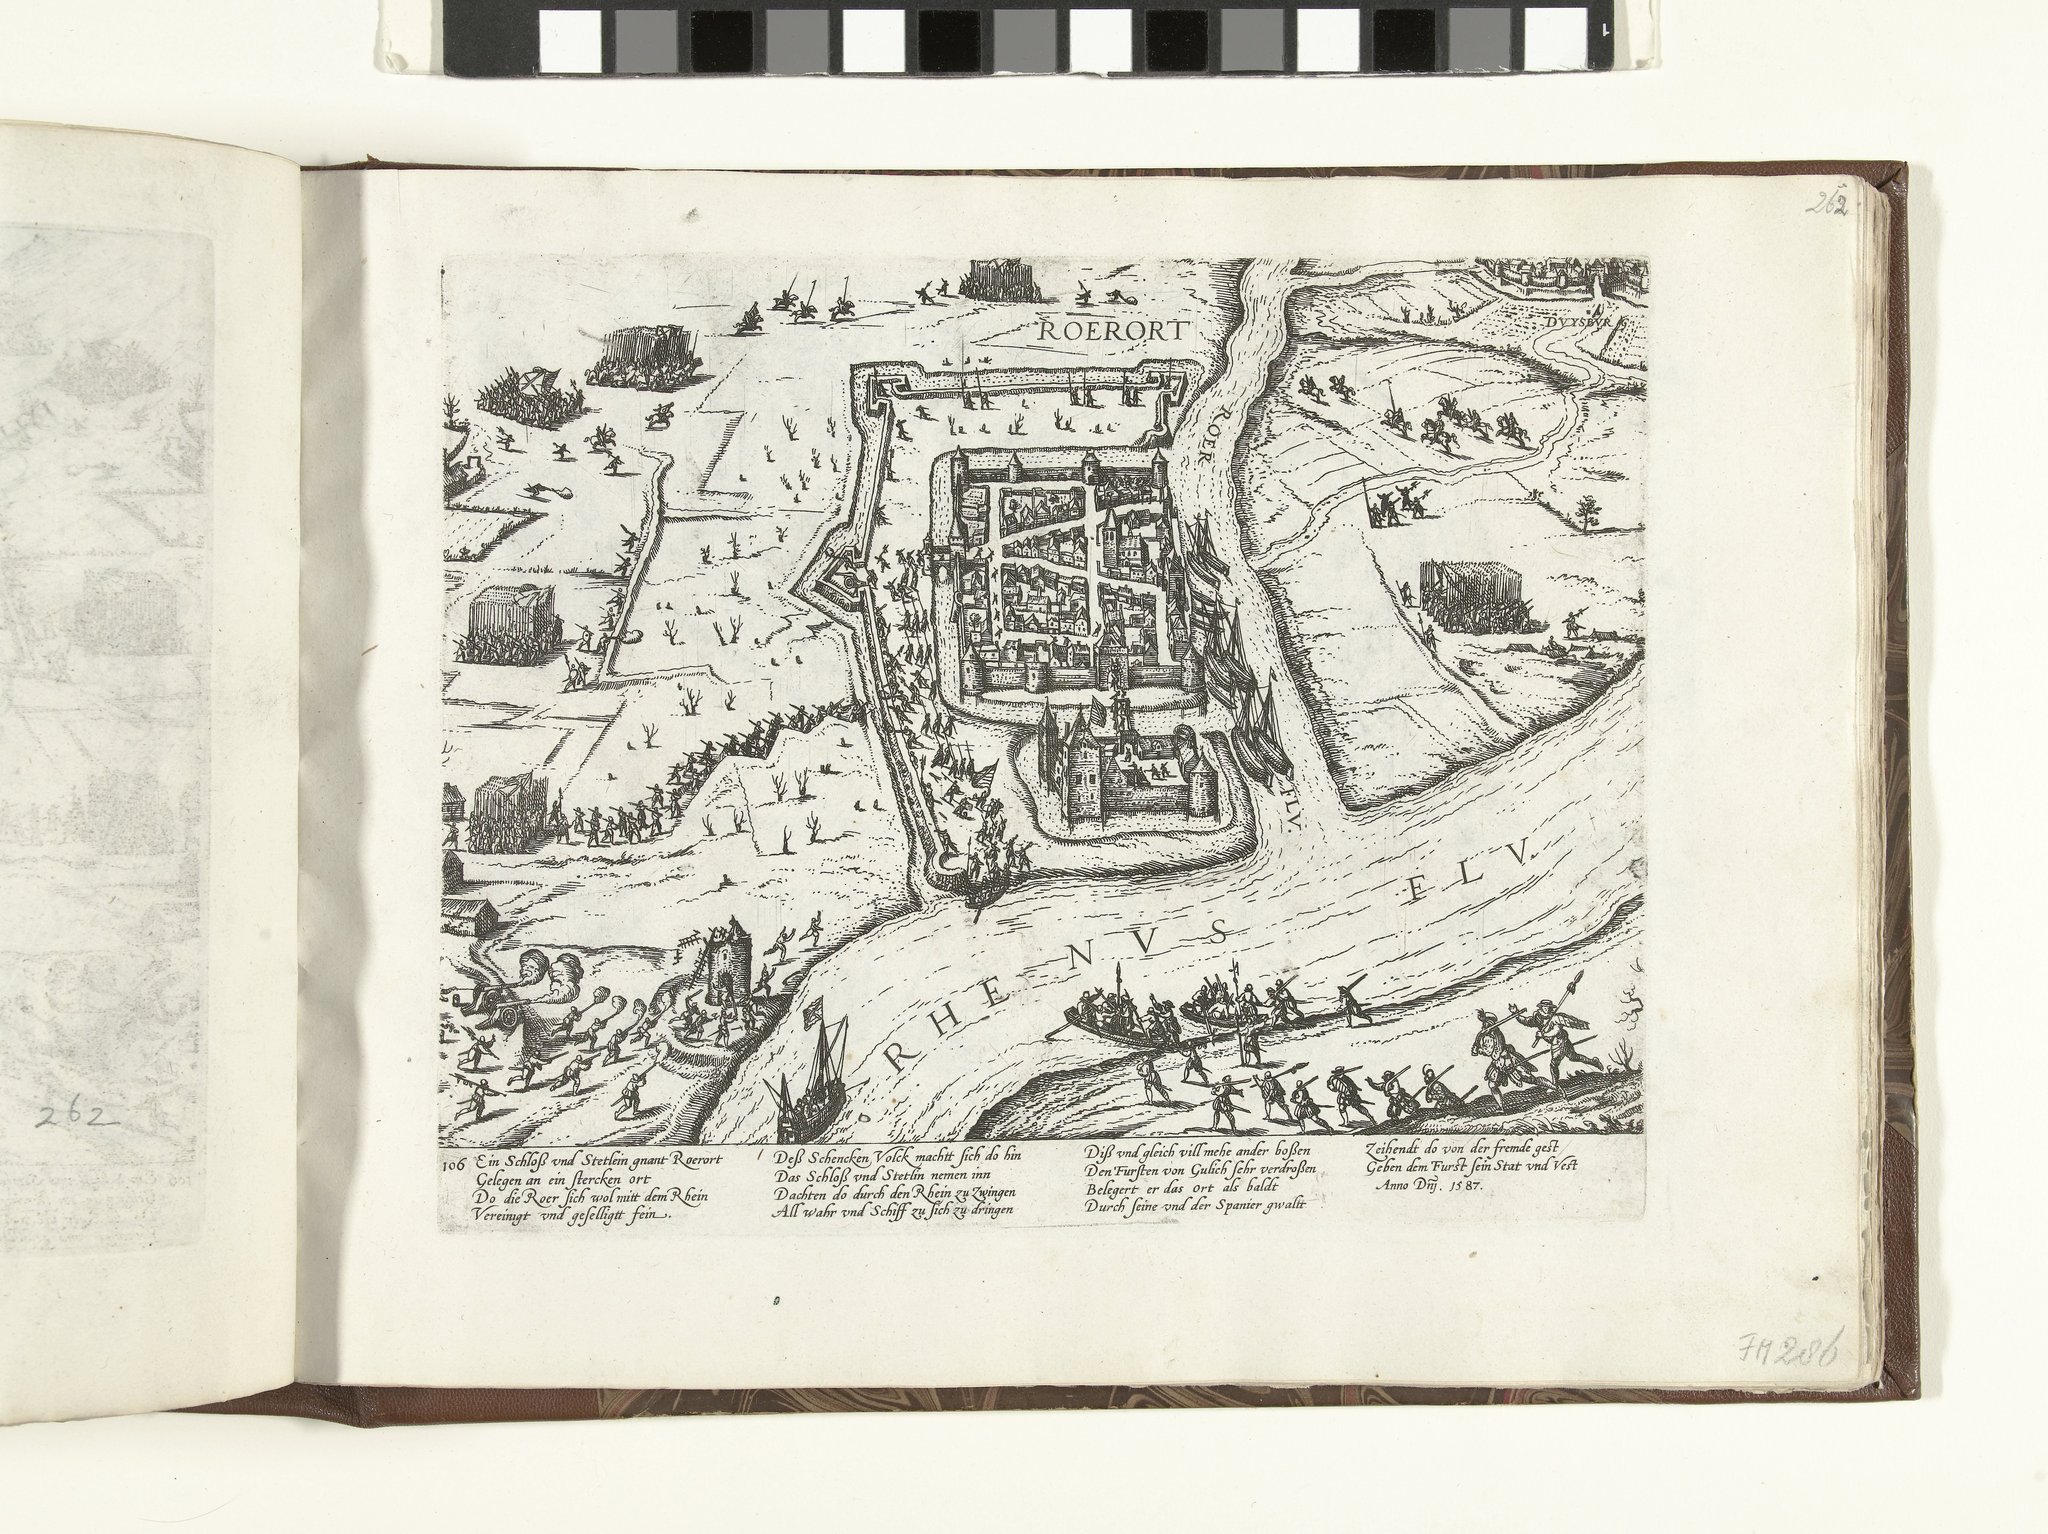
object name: print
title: Serie 9: Nederlandse en Duitse Gebeurtenissen, 1583-1587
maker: frans hogenberg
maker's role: print maker, publisher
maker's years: 1538-1590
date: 1587-1589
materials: paper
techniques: etching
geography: cologne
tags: nijmegen, capture of city (after the siege)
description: Ruhrort veroverd op de troepen van Schenck, januari 1587. Episode uit de Keulse Oorlog. Met onderschrift van 14 regels in het Duits. Genummerd: 106.